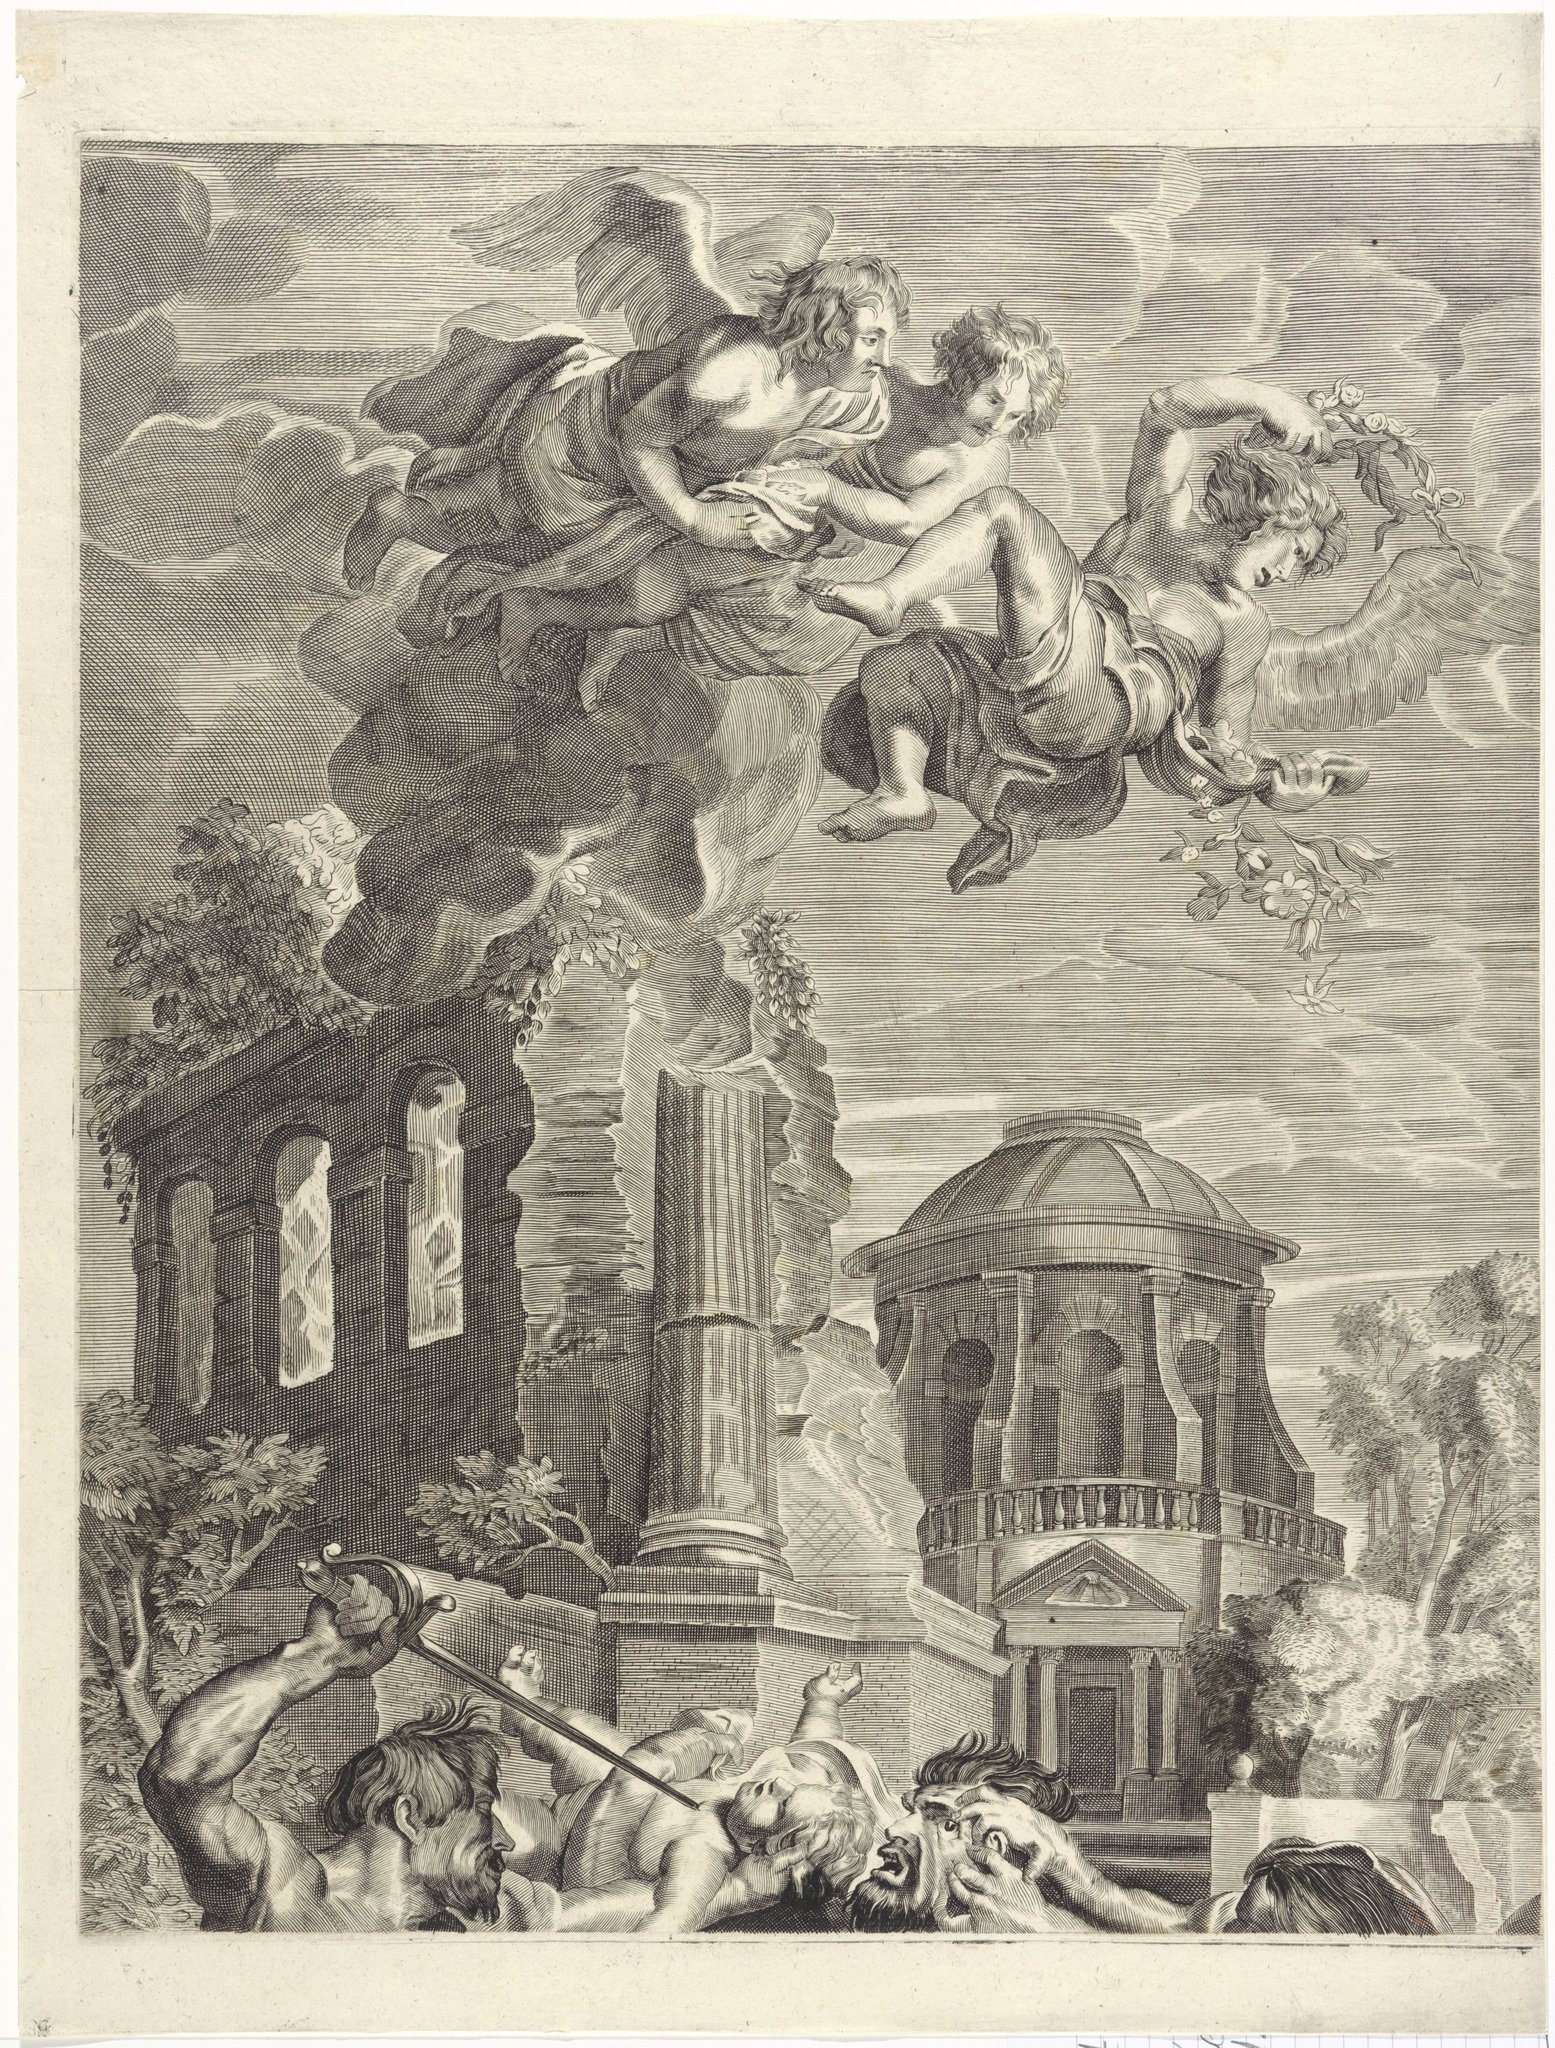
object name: print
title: Kindermoord te Betlehem, linksboven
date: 1668-1693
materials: paper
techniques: engraving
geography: amsterdam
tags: the massacre of the innocents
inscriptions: collector's mark: Lugt 240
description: Fragment van de kindermoord te Betlehem. Nabij Herodes' paleis vindt een grote slachtpartij plaats. Soldaten rukken kinderen uit de armen van wanhopige moeders om ze met zwaarden te doden. Vanuit de lucht kijken drie engelen toe.